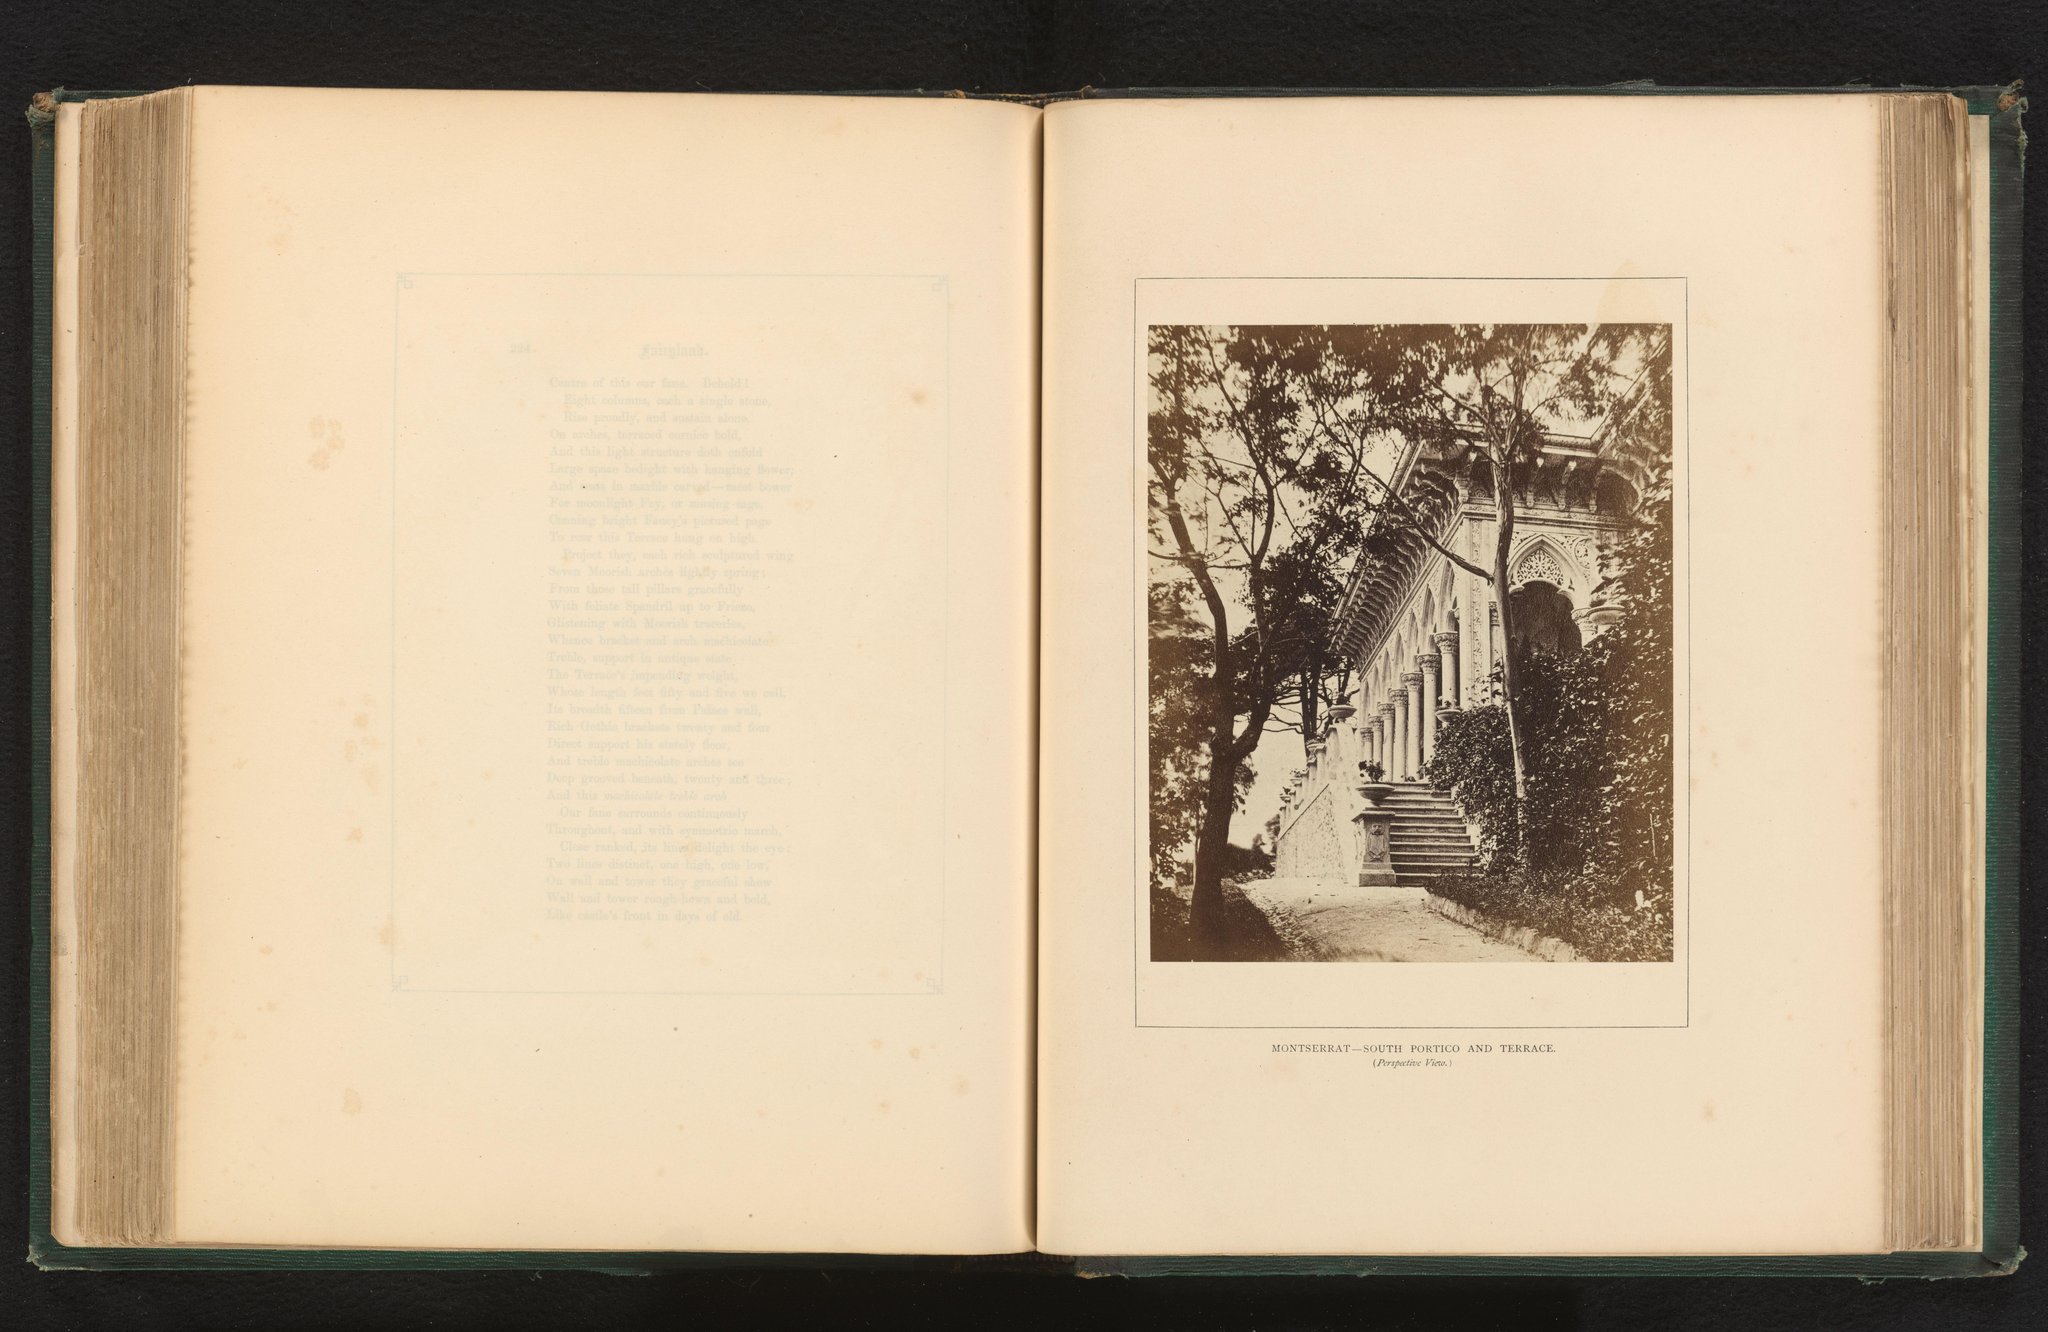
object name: page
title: Gezicht op de zuidelijke portico van het Palácio de Monserrate nabij Sintra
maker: Anonymous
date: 1865-1870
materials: paper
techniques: albumen print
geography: sintra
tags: colonnade, palace, gate, entrance, terrace